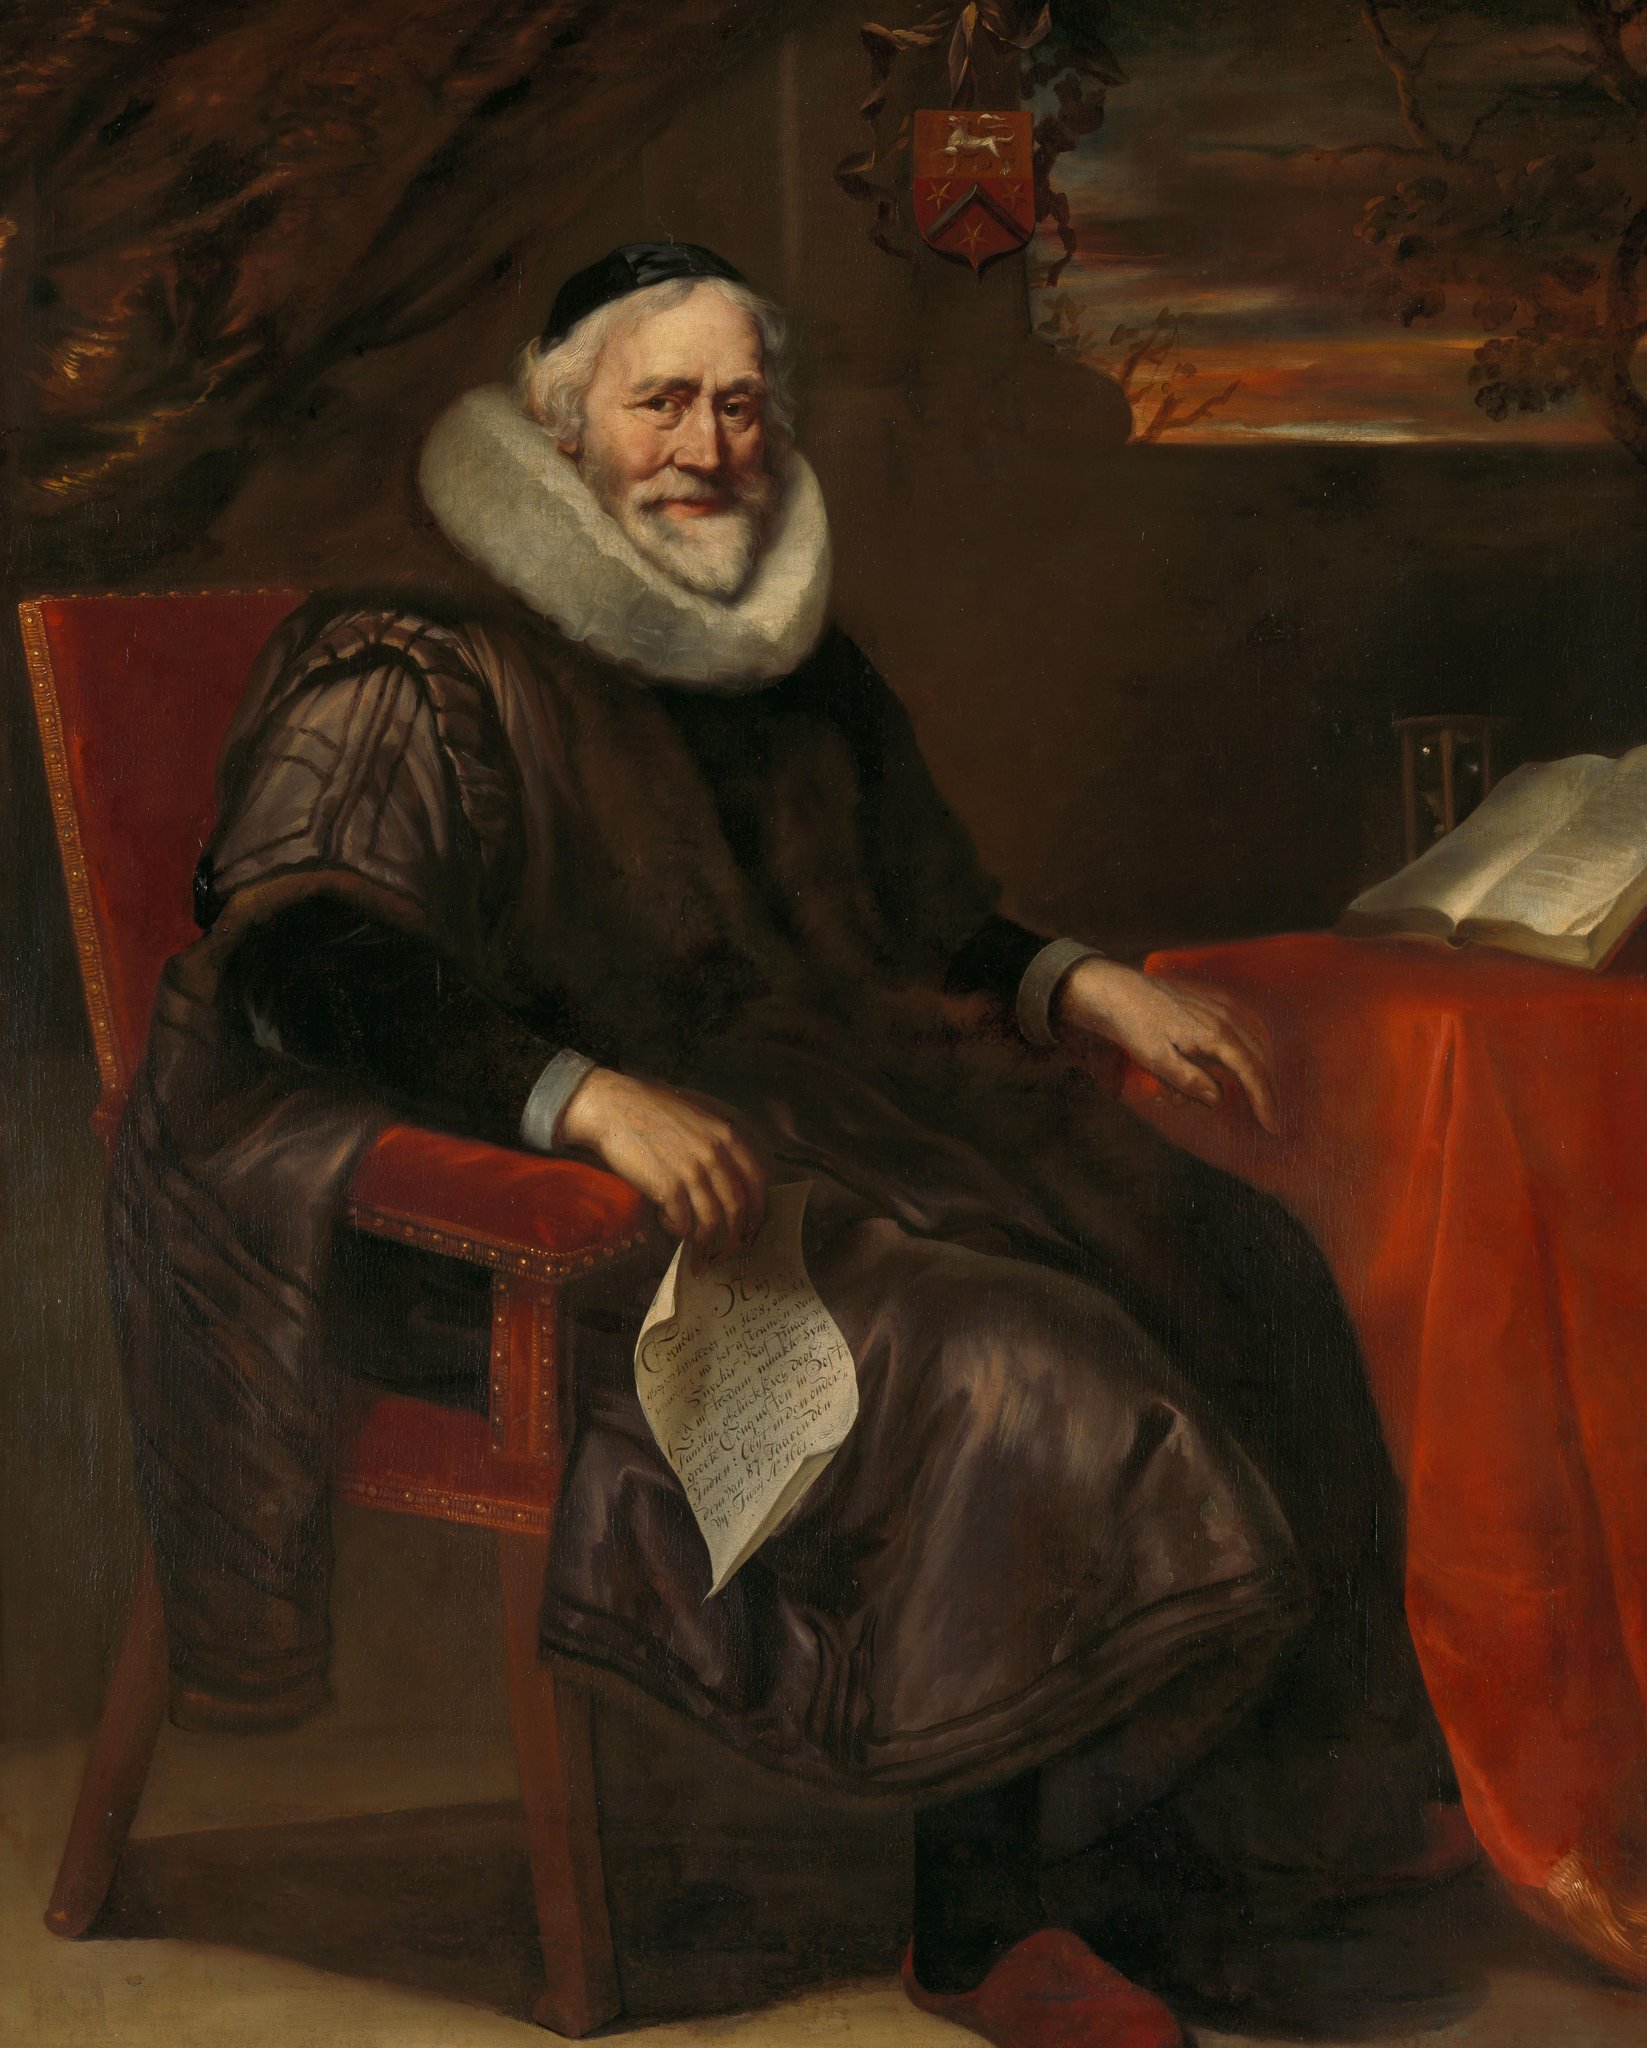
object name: painting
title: Cornelis Nuyts (1574-1661). Amsterdam merchant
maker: jürgen ovens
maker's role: draughtsman, painter, print maker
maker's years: 1623-1678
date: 1658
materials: canvas, oil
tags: historical persons, merchant, salesman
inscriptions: inscription: ‘Cornelis Nuy[ts] gheportraiteert in 1658, oud 84 jaeren; na het afbranden van [zijn] suycker raffinaderye 't Amsterdam maakte syne familije gheluckkich door groote conquesten in Oost Indien; Obijt in den ouderdom van 87 jaaren den vij junij Aº 1661.’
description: Portret van Cornelis Nuyts (1574-1661), koopman te Amsterdam. Ten voeten uit, zittende in een stoel bij een tafel waarop een opengeslagen boek en zandloper. In de rechterhand een blad papier met opschrift. Rechtsboven het familiewapen.